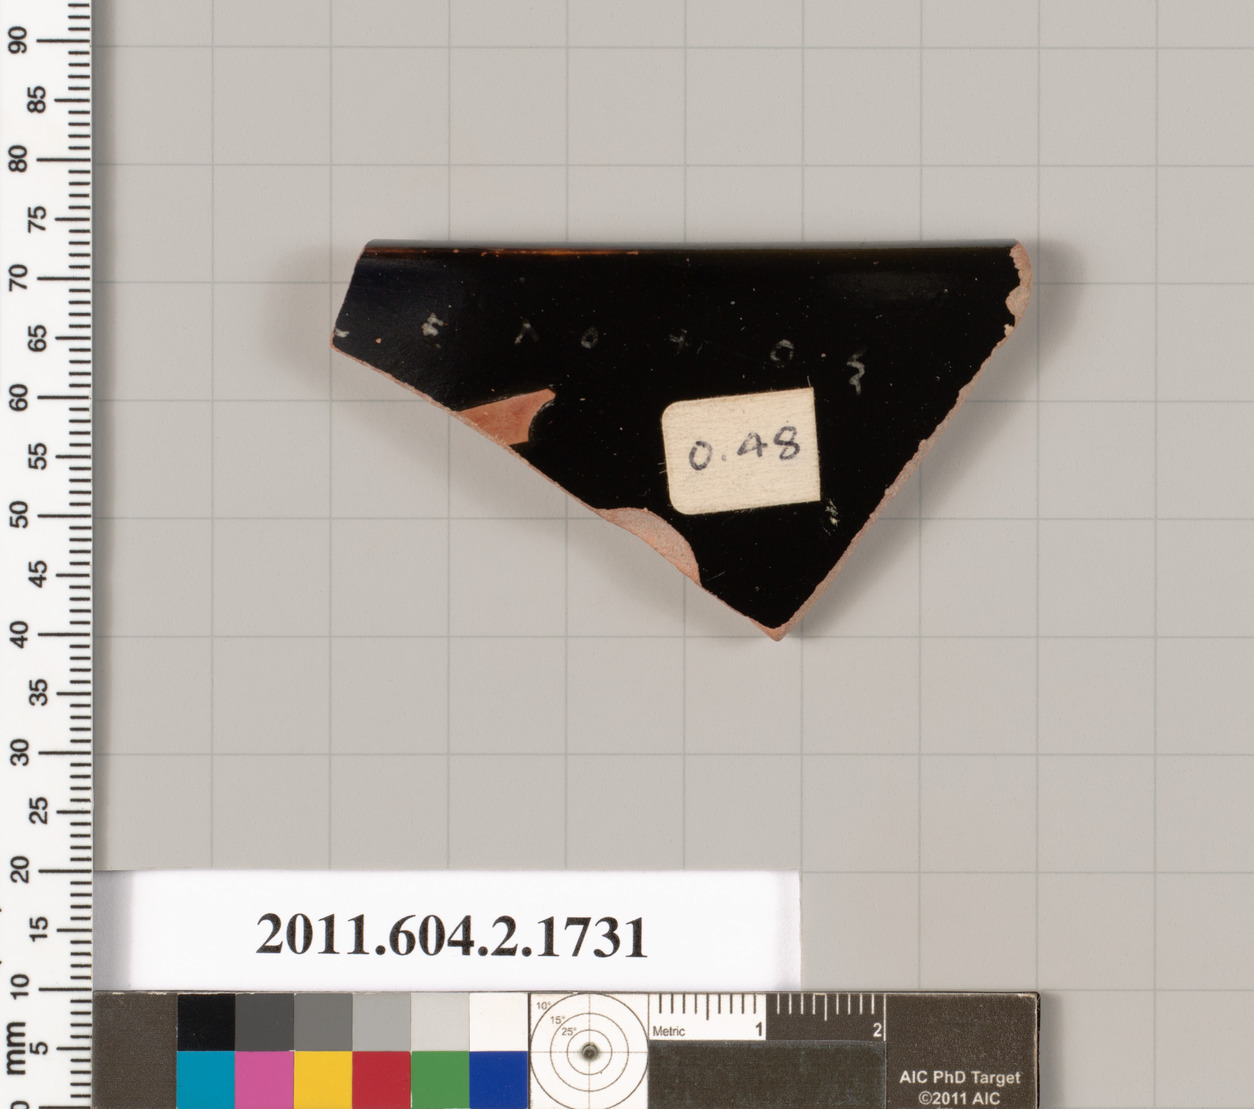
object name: skyphos fragment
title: Terracotta rim fragment of a skyphos (deep drinking cup)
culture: greek, attic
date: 475-451 BCE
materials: terracotta